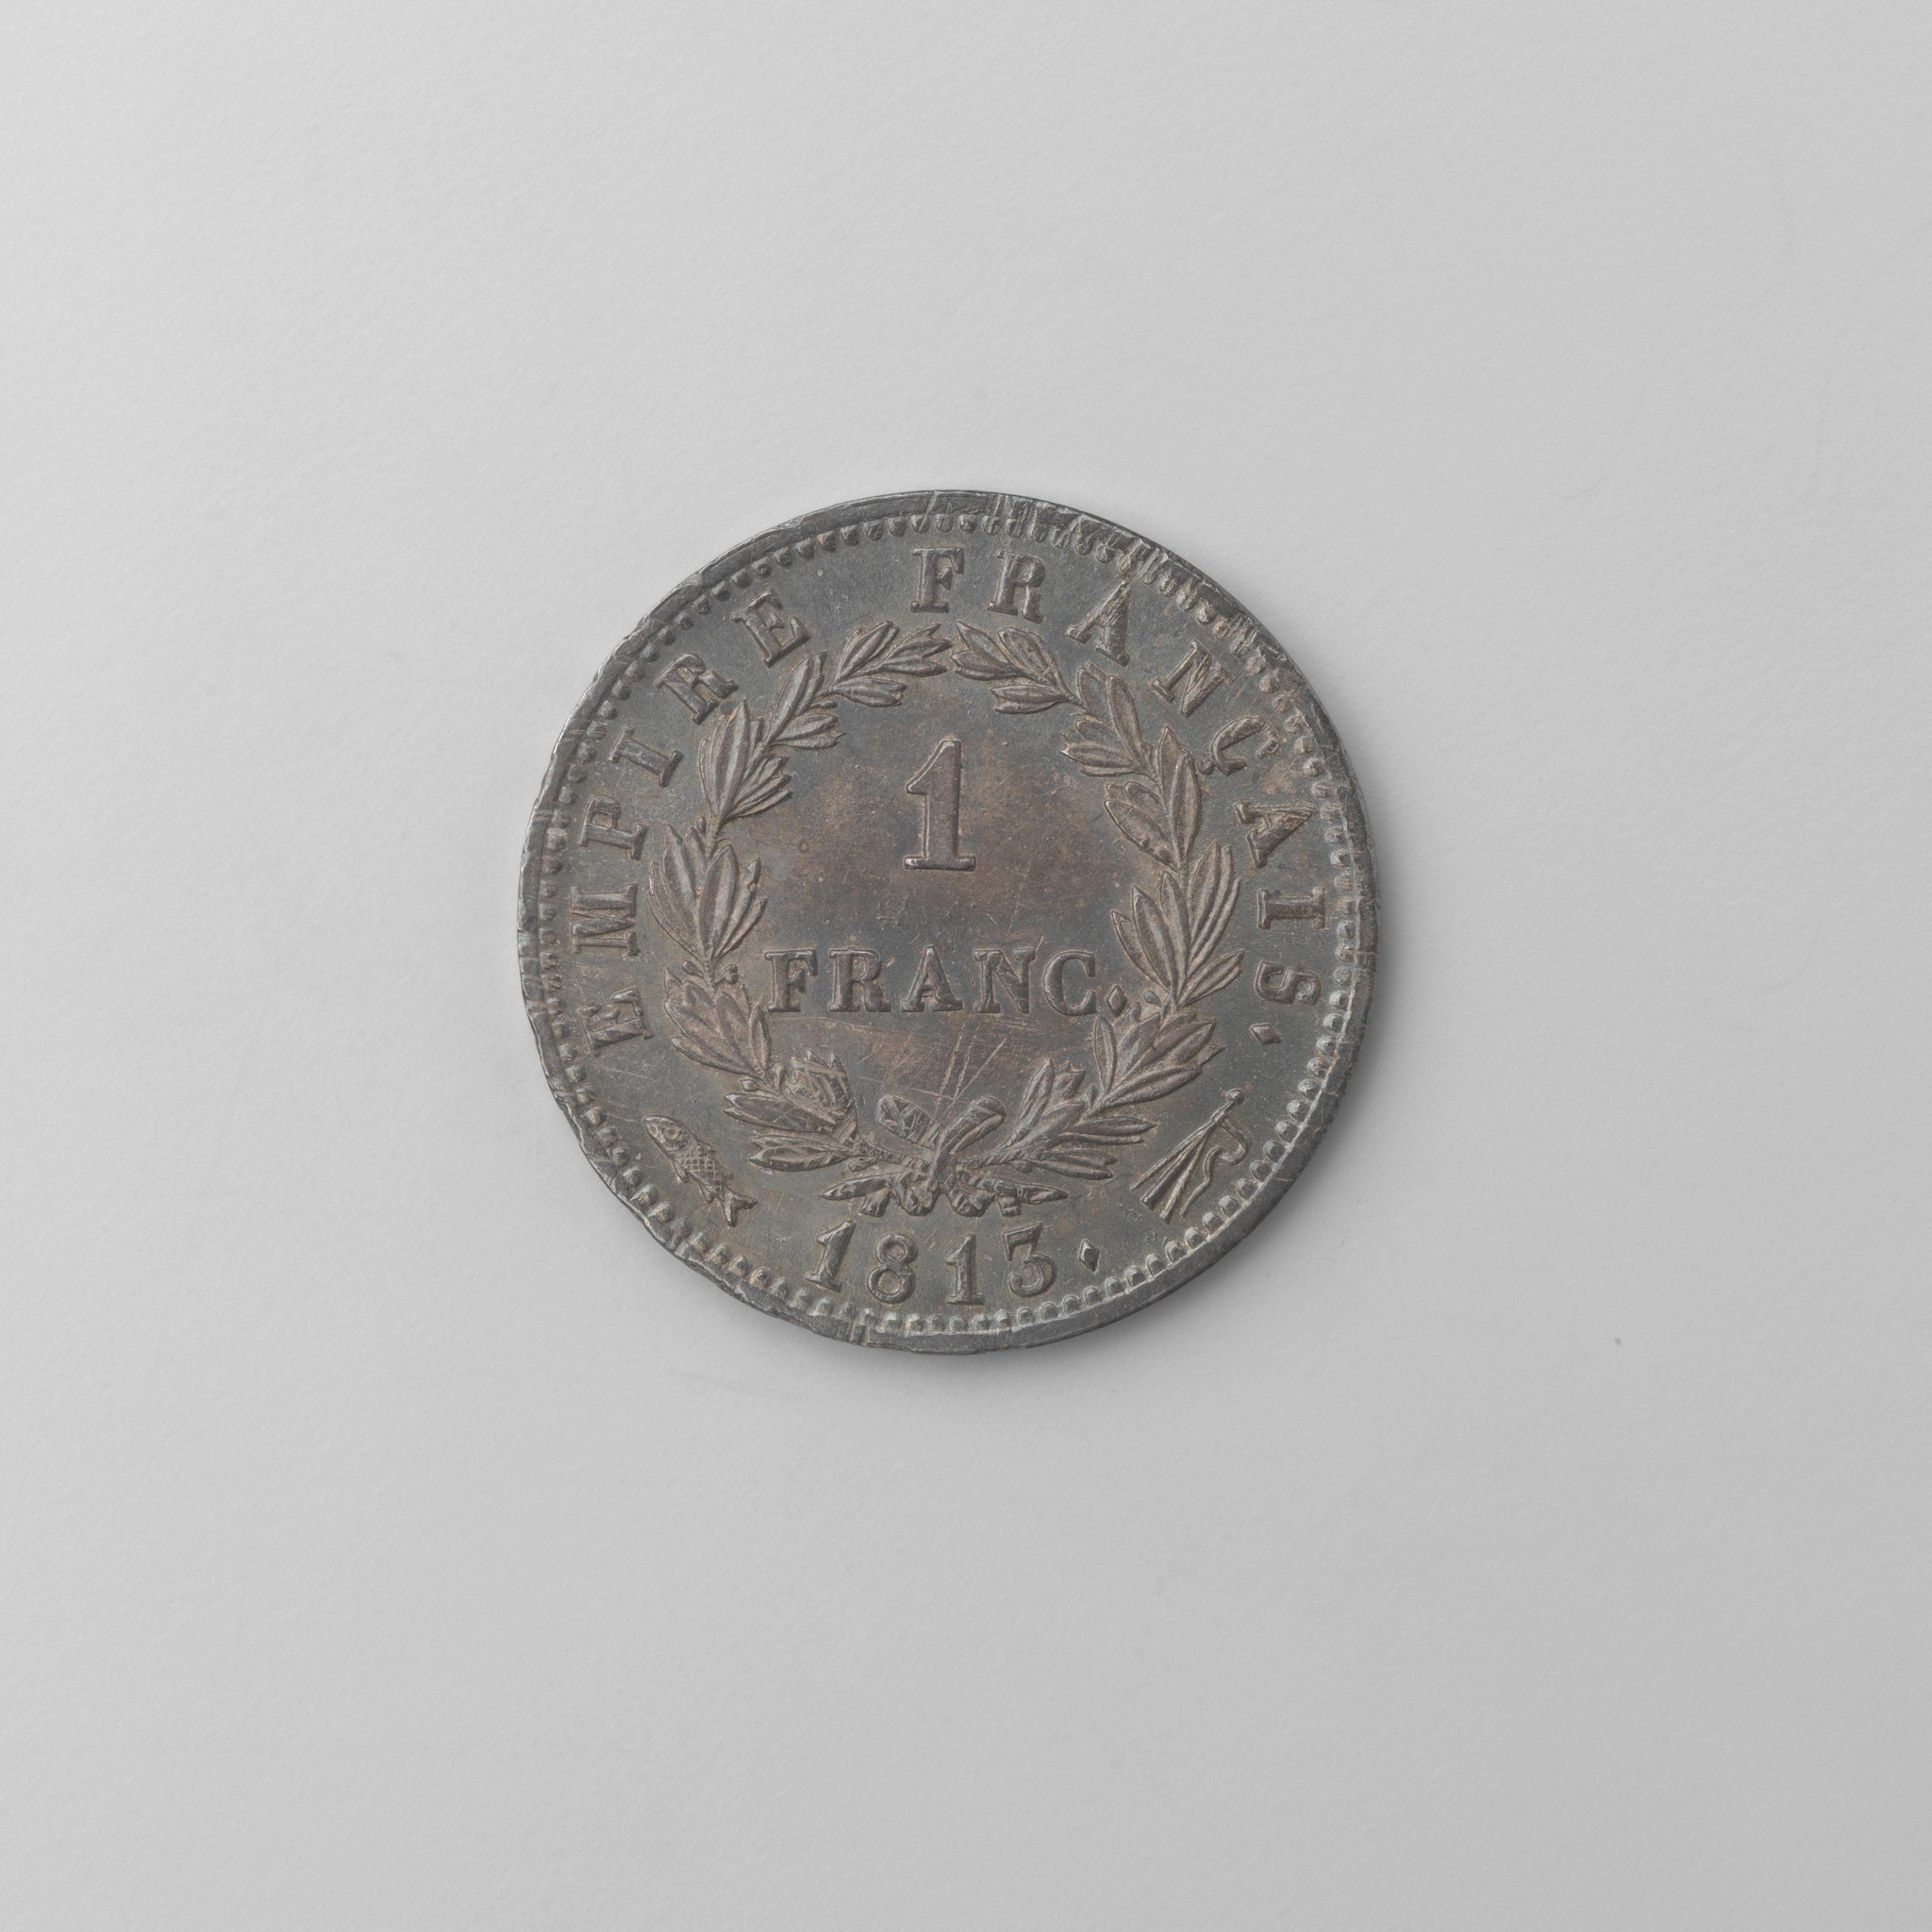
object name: coin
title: Nederlandse franc, 1813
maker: napoleon i (emperor of the french)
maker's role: generaal, keizer, staatsman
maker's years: 1769-1821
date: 1813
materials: silver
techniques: striking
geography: utrecht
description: Zilveren munt. Voorzijde: gelauwerd borstbeeld van Napoleon I naar rechts. Keerzijde: binnen olijfkrans waarde-aanduiding 1 franc. Jaartal in omschrift onderaan. Randschrift.